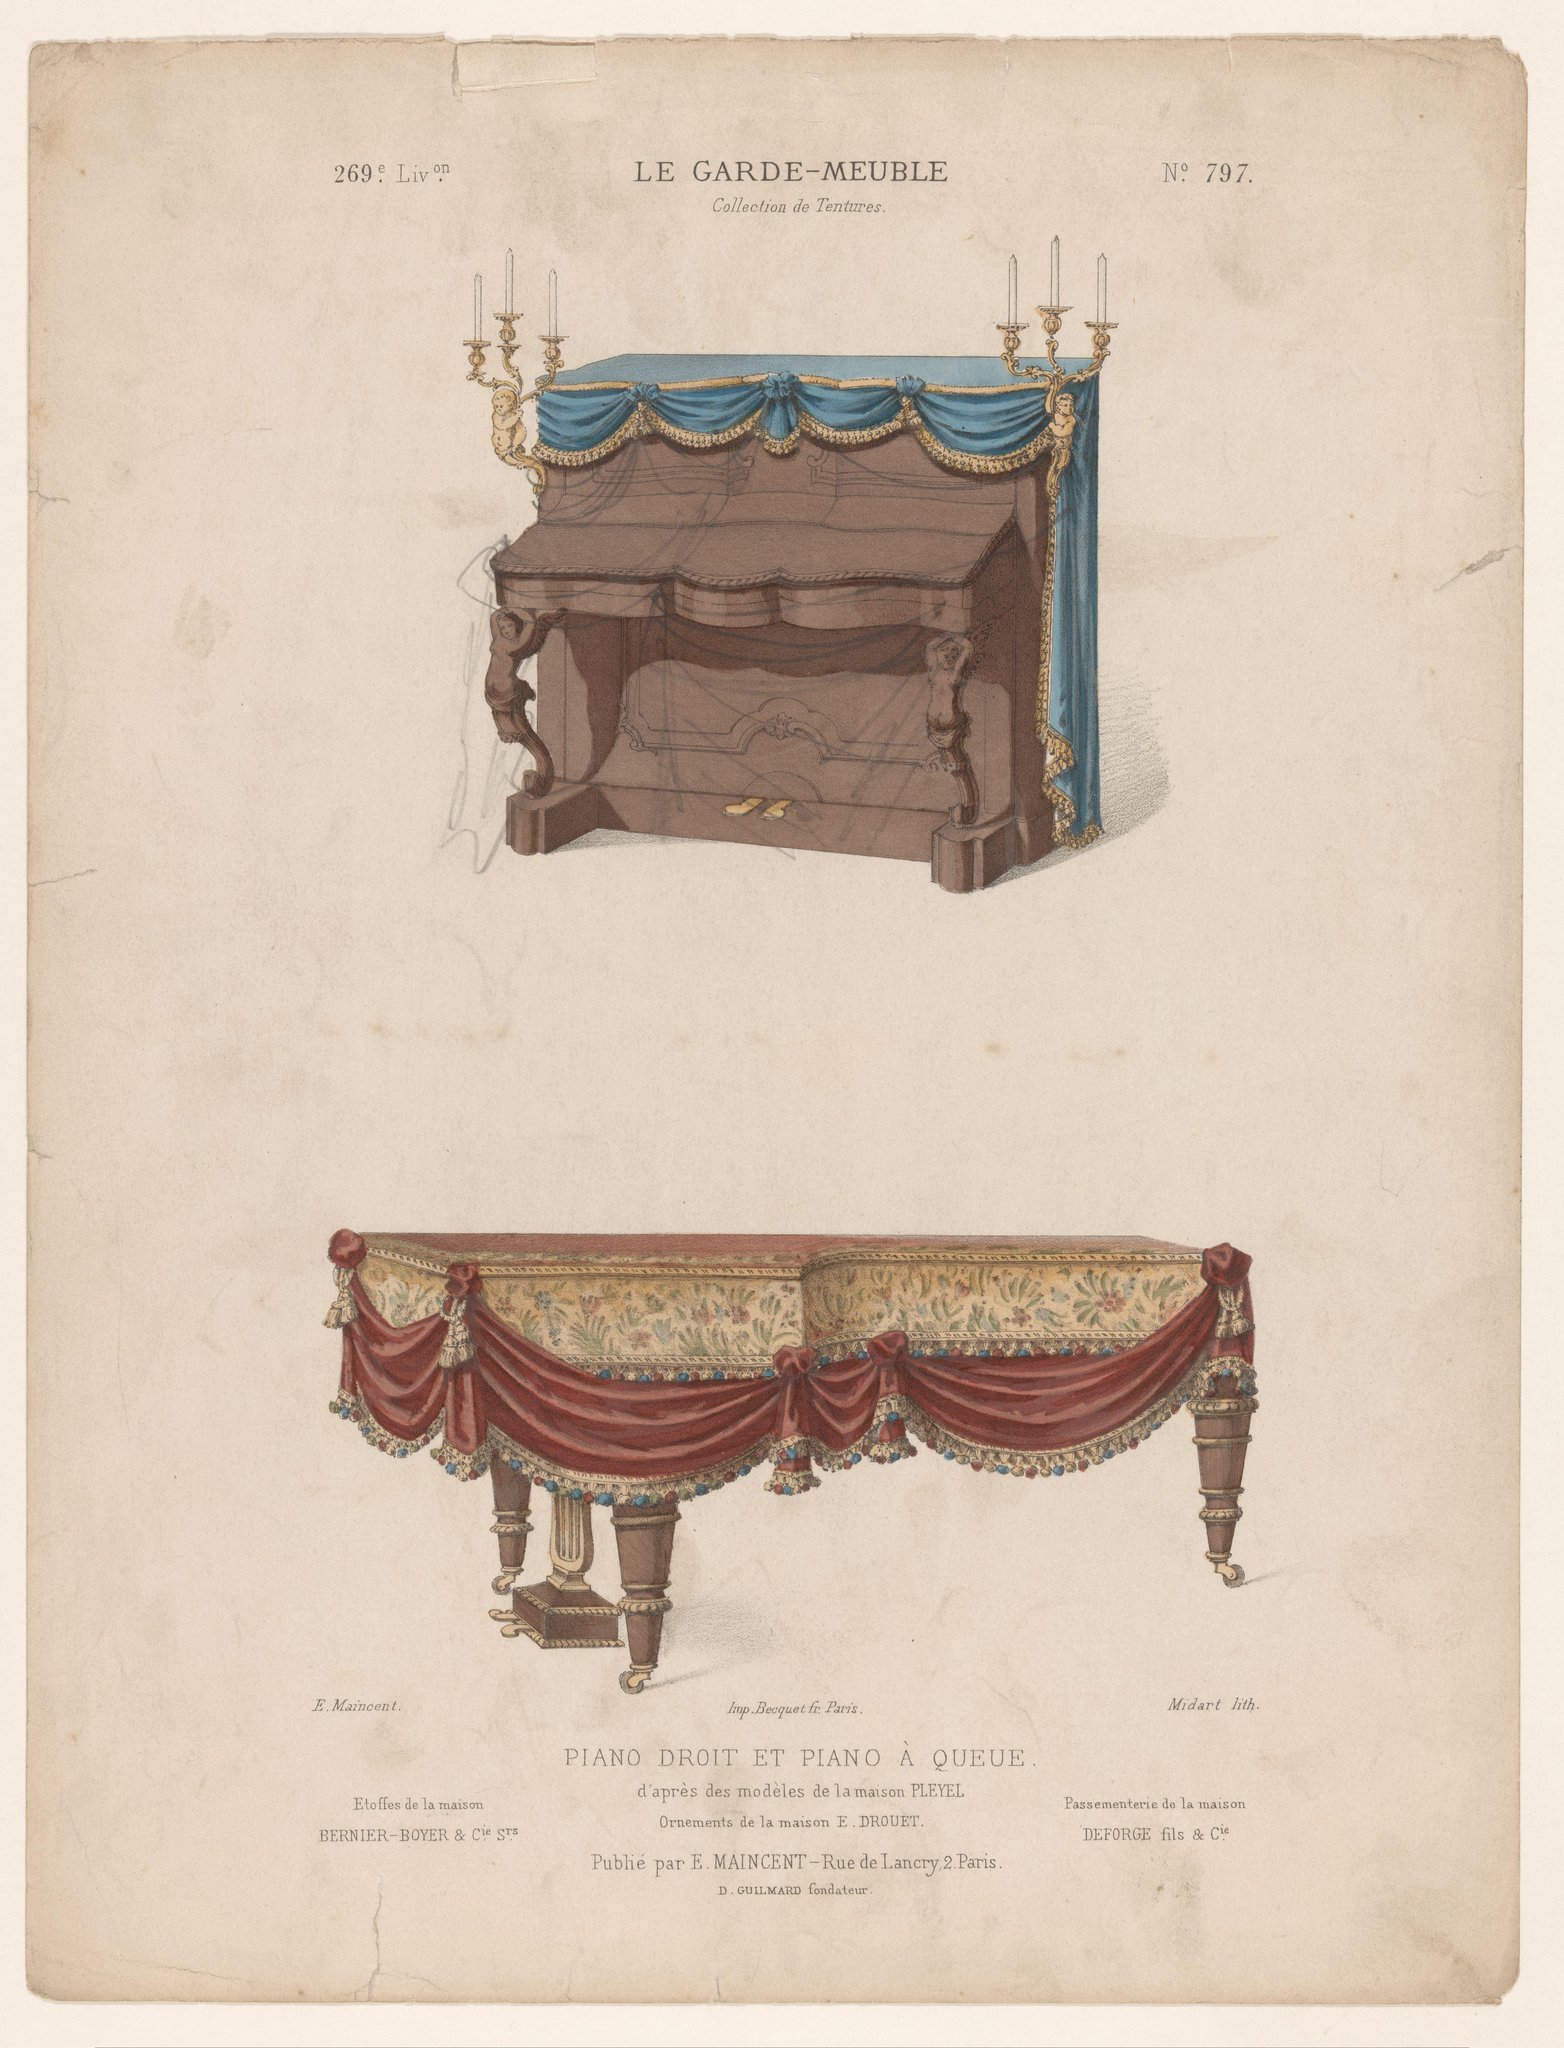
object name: print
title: Piano en vleugel met draperieën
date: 1885-1895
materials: paper, pencil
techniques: hand coloring, lithograph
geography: paris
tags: grand piano, hangings and drapery, pianoforte